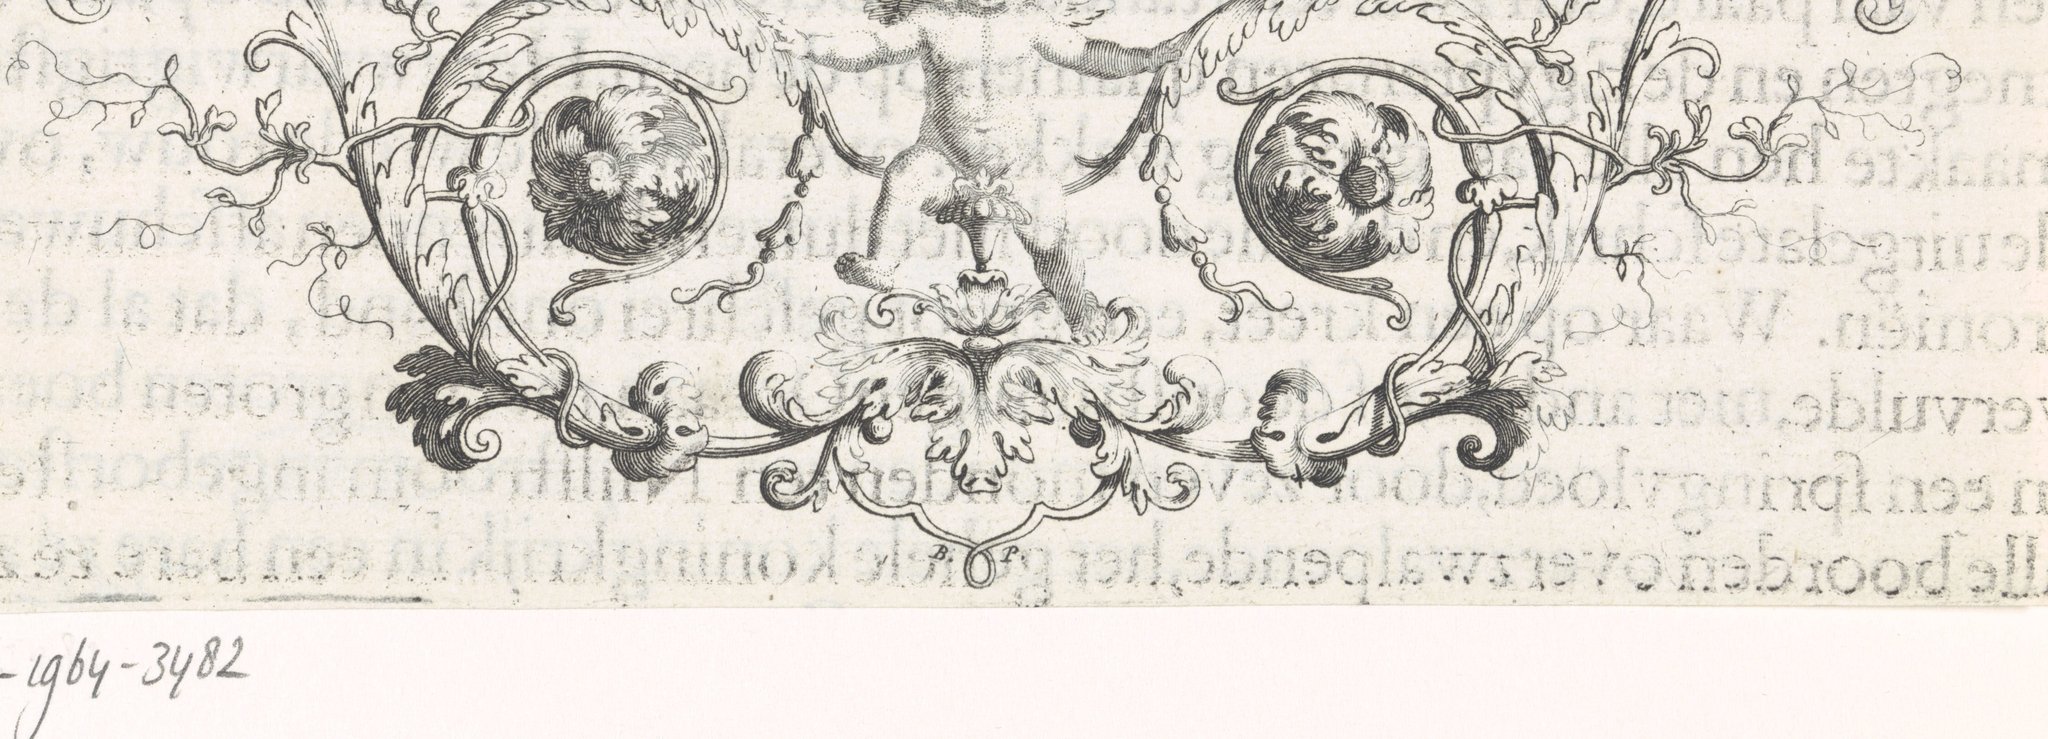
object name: book illustration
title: Ornament met bladranken en putto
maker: bernard picart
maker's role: draughtsman, print maker, publisher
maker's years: 1673-1733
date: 1683-1733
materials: paper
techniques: engraving, etching, letterpress printing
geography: amsterdam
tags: foliage, tendrils, branches ~ ornament, cupids: 'amores', 'amoretti', 'putti'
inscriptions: collector's mark: Lugt 2228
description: Prent oorspronkelijk bedoeld voor: Figures de la Bible. Amsterdam, Bernard Picart, 1720. Prent ook gebruikt in: Taferelen der voornaamste geschiedenissen van het Oude en Nieuwe Testament (...) door de vermaarde kunstenaars Hoet, Houbraken, en Picart getekent (...) en met beschrijvingen uitgebreid. Den Haag: Pieter de Hondt, 1728. Prent kan mogelijk ook zijn gebruikt in andere bijbels.